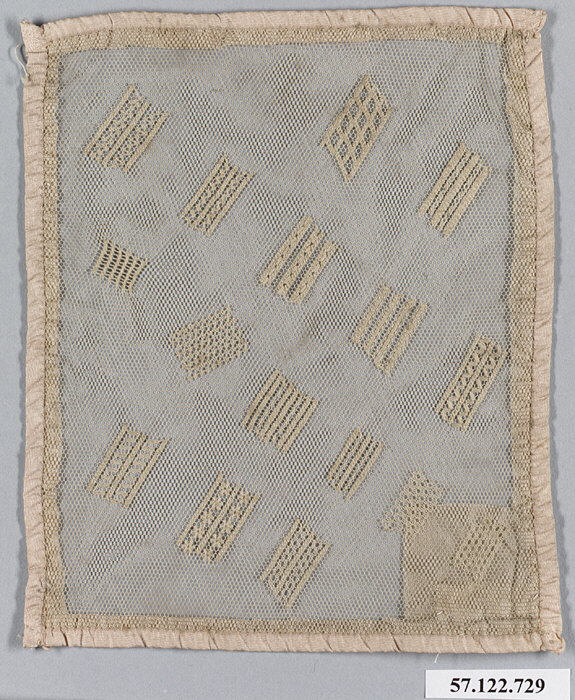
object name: sampler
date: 1801-1900